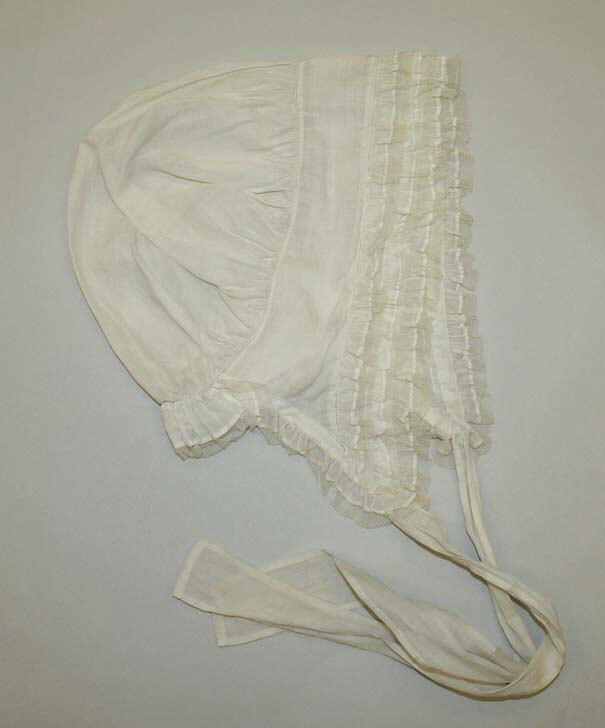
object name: cap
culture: american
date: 1801-1833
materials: linen